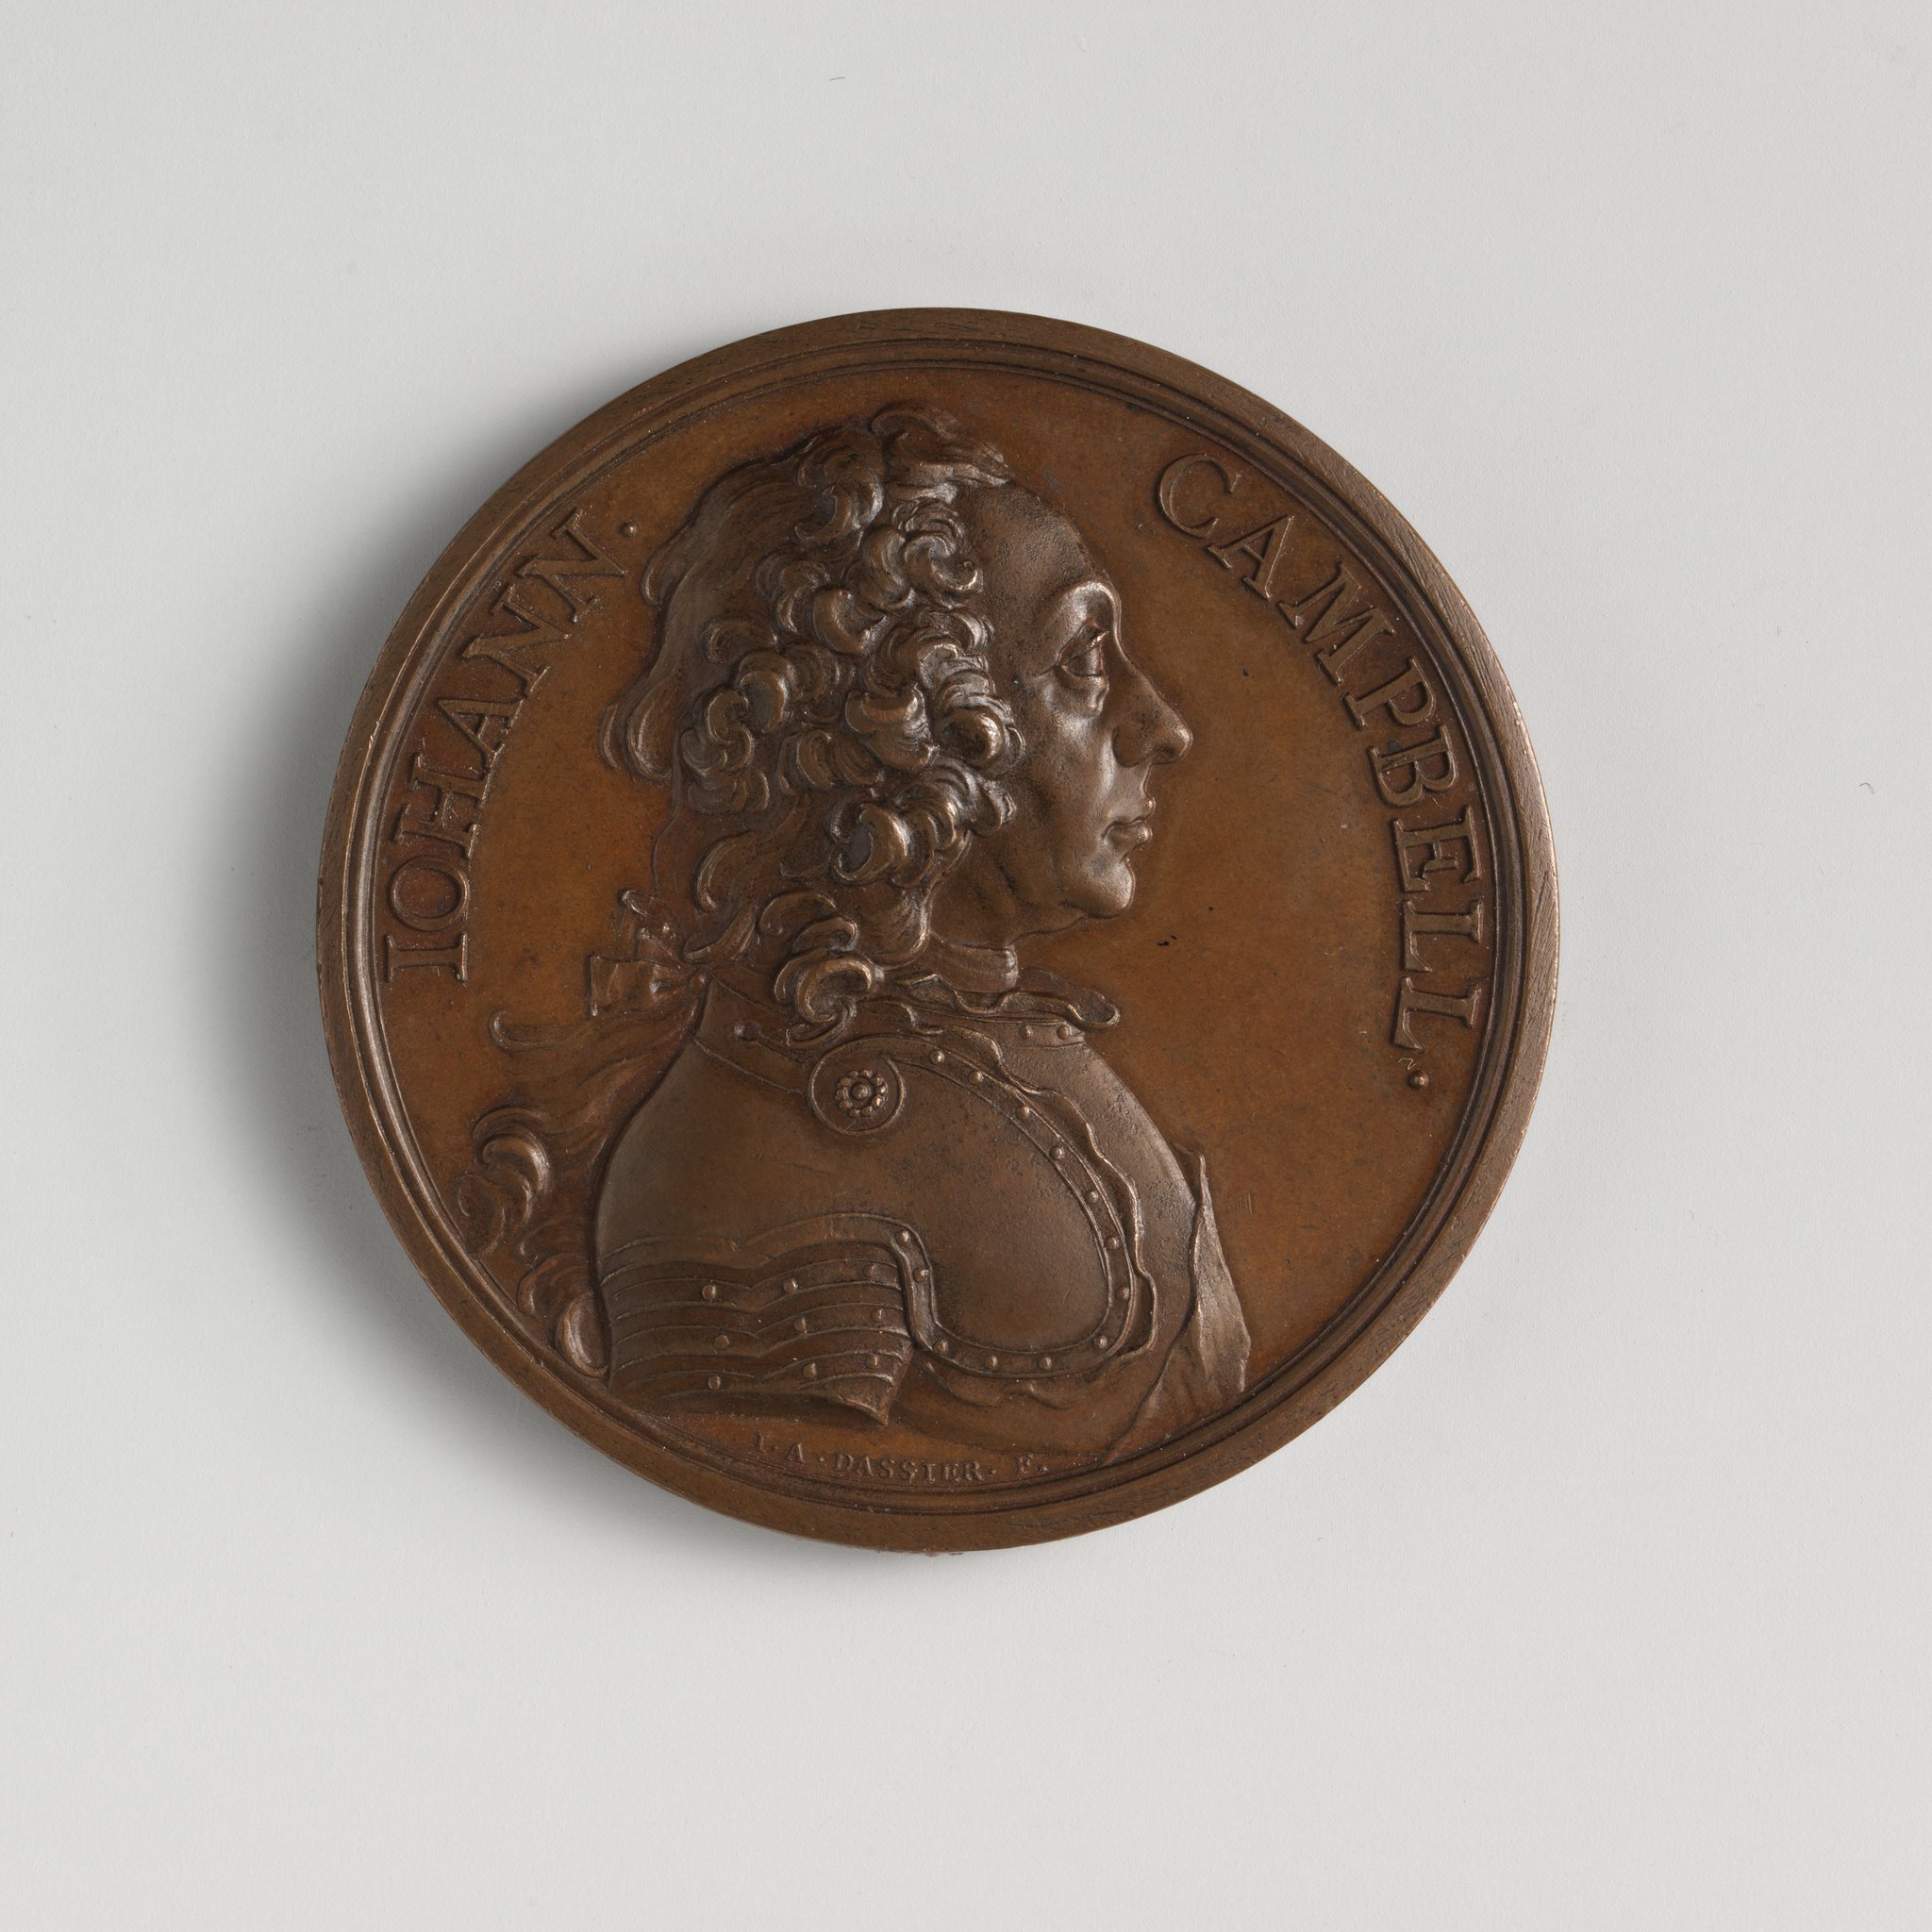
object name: medal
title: John Campbell, 2nd Duke of Argyle, 1st Duke of Greenwich (1680–1743)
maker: jacques-antoine dassier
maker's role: artist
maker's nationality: swiss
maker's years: 1715-1759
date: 1743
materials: bronze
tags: men,profiles